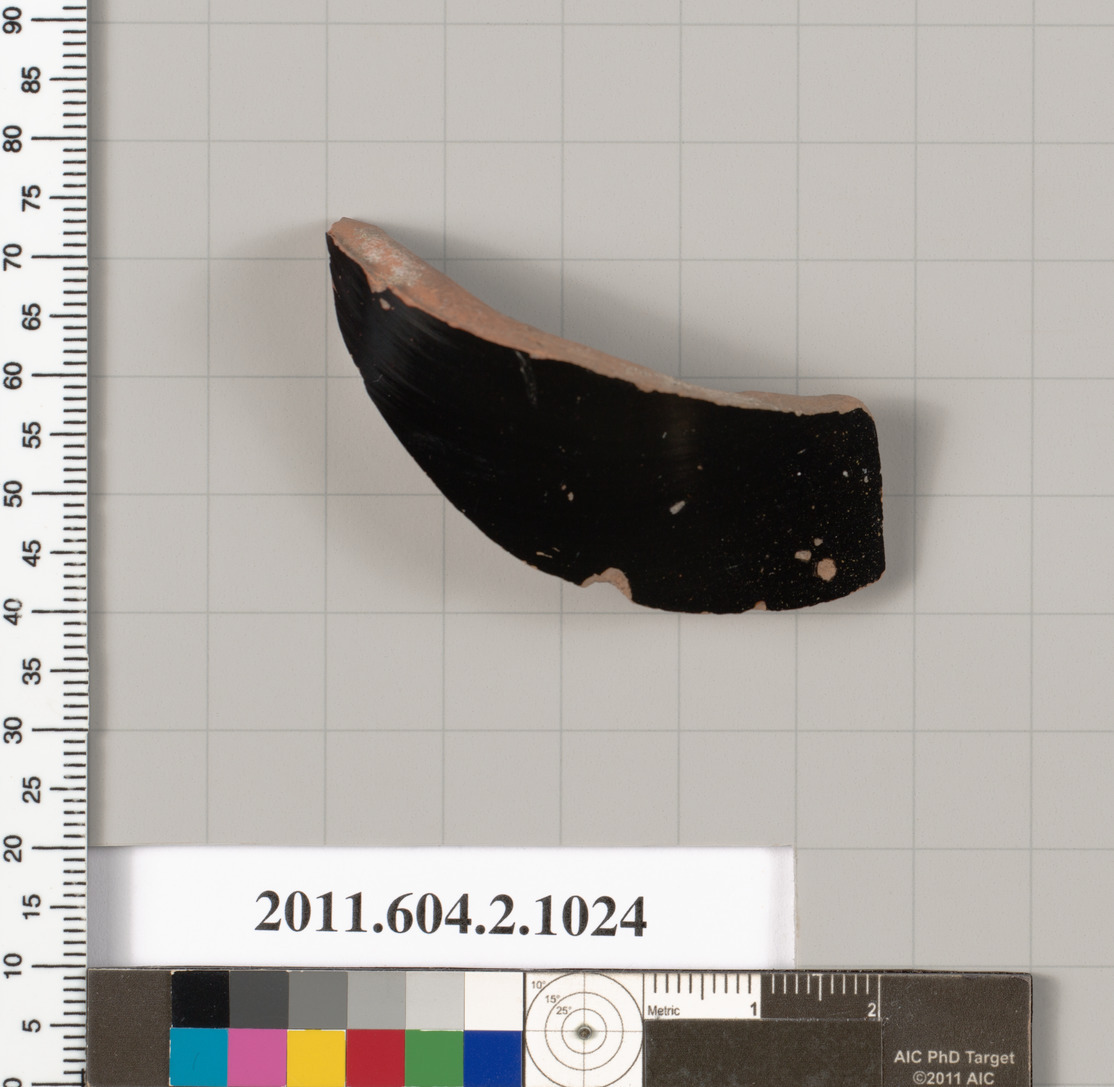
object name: oinochoe fragment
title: Terracotta fragment of an oinochoe (jug)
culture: greek, attic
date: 475-425 BCE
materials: terracotta